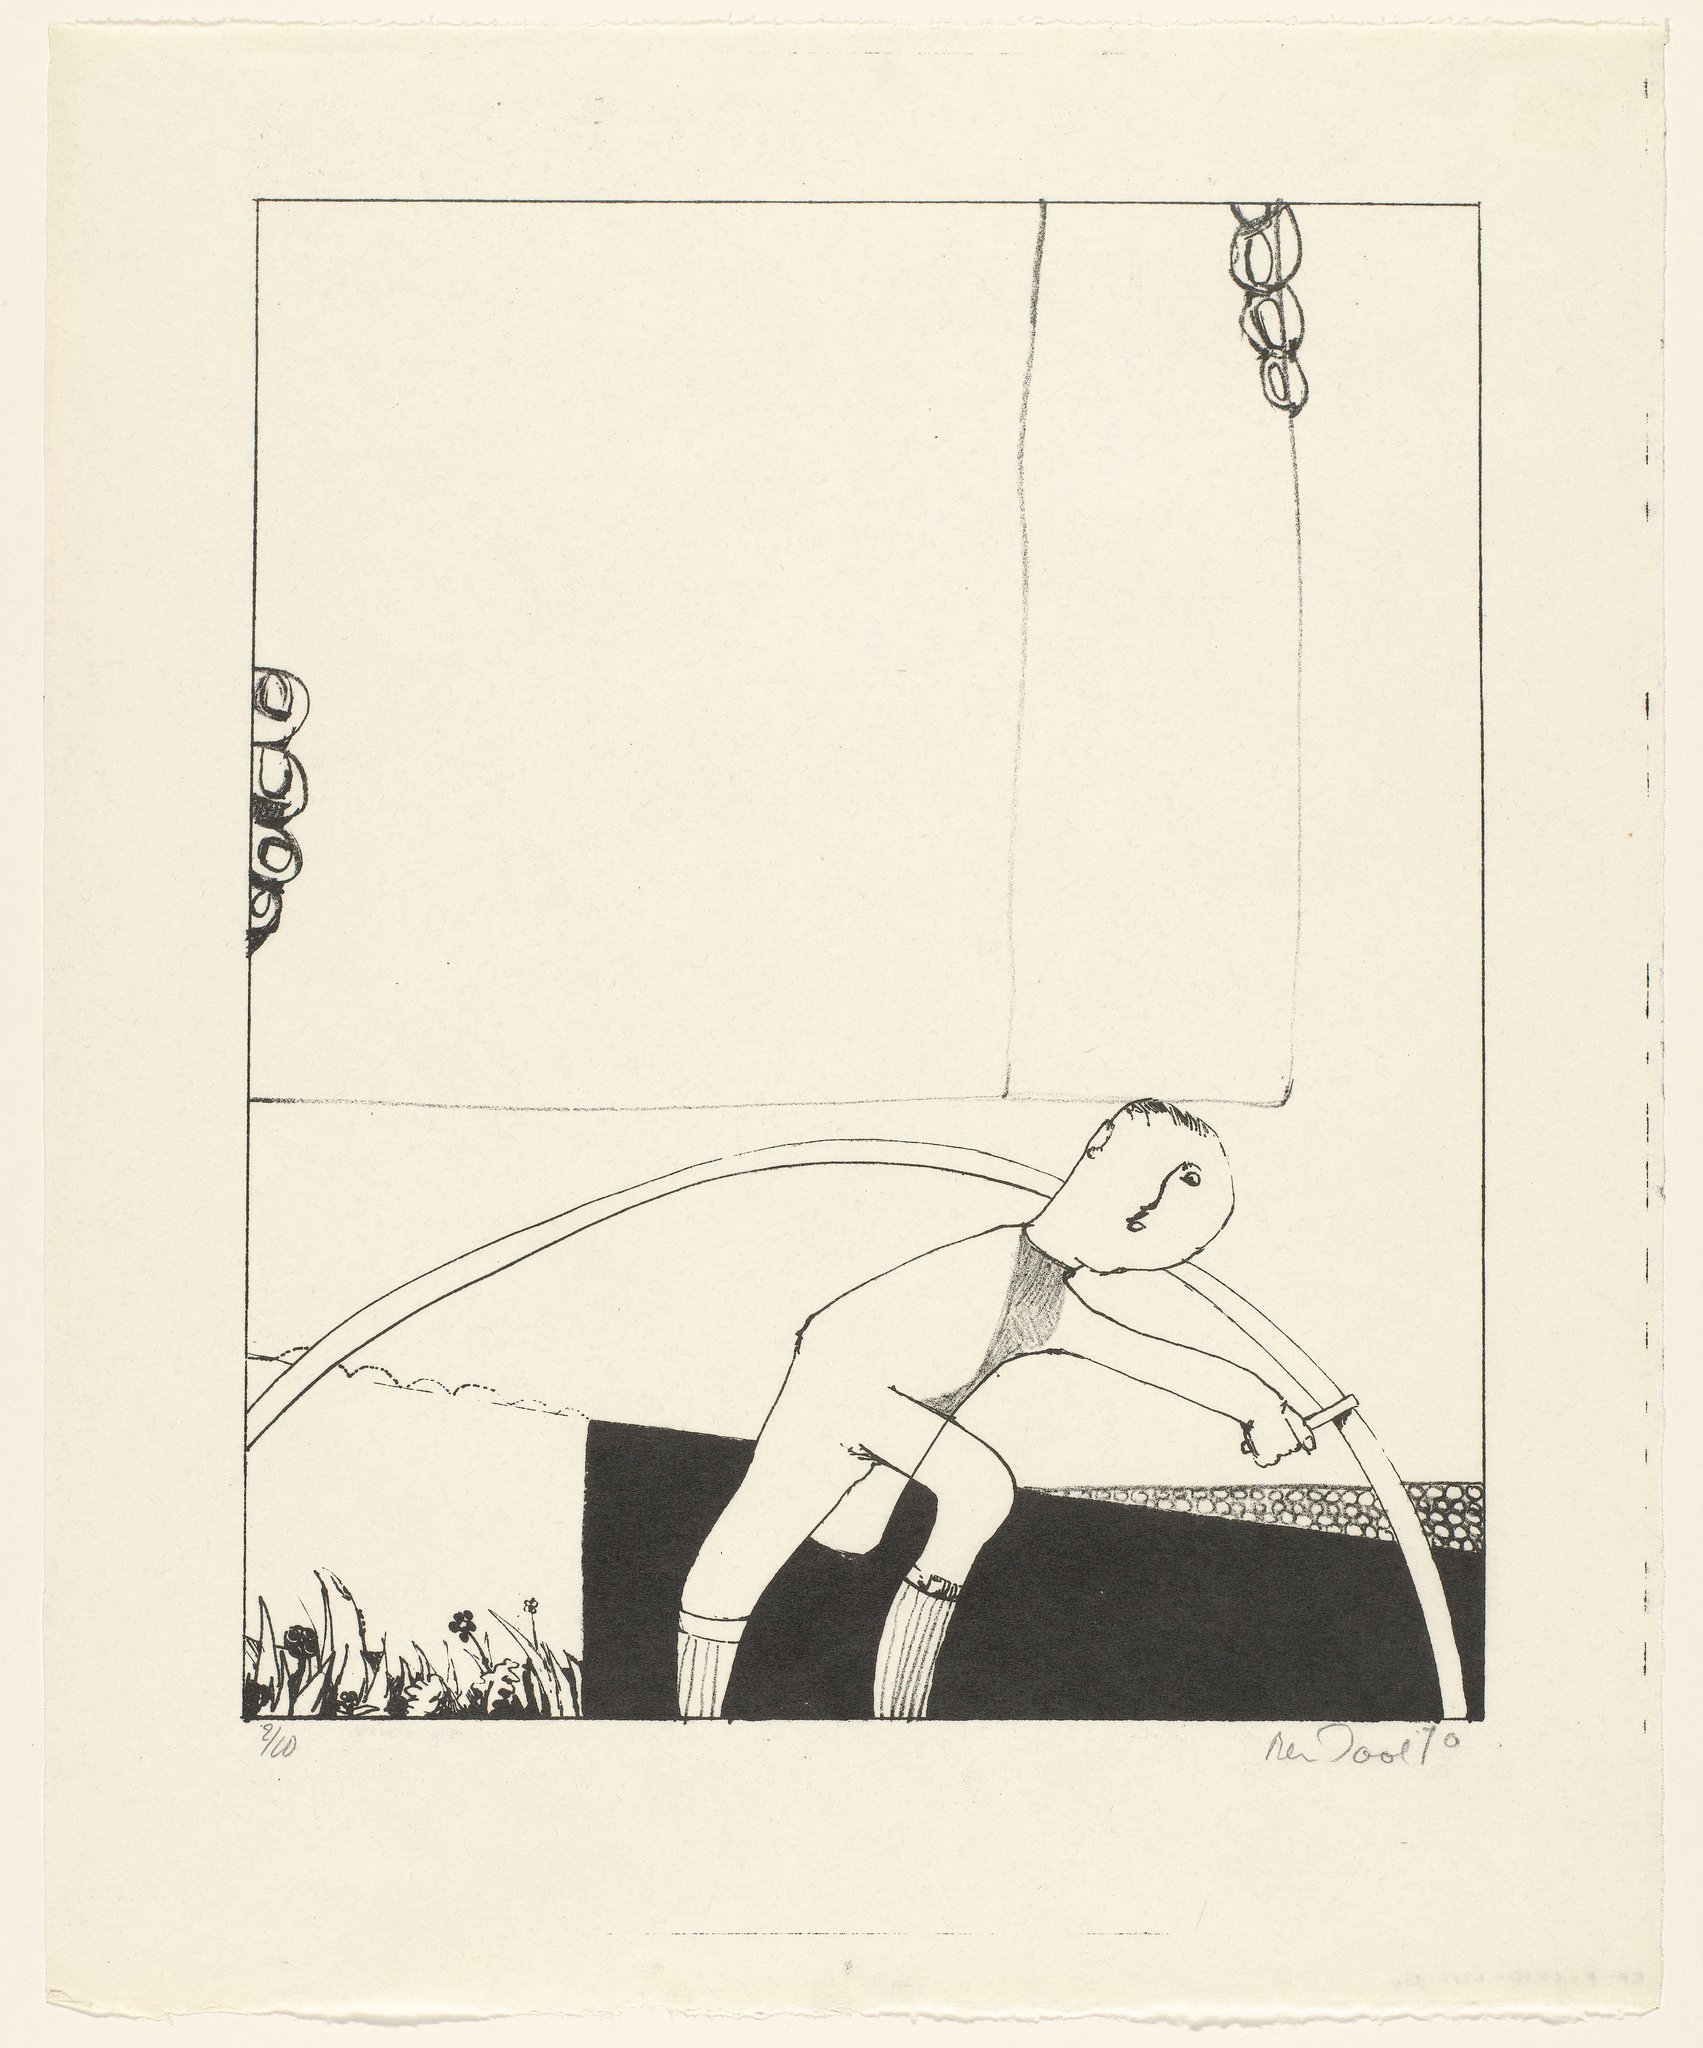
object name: print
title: Jongen bij halve boog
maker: rein dool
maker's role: draughtsman, painter, print maker, sculptor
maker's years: 1933-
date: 1970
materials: paper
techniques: lithograph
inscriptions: signature and date: ‘Rein Dool 70’, edition: ‘2/10’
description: Onder een eenogige jongen bij halve boog, boven een vierkant object dat wordt vastgehouden door twee handen waarvan de vingertoppen zichtbaar zijn.